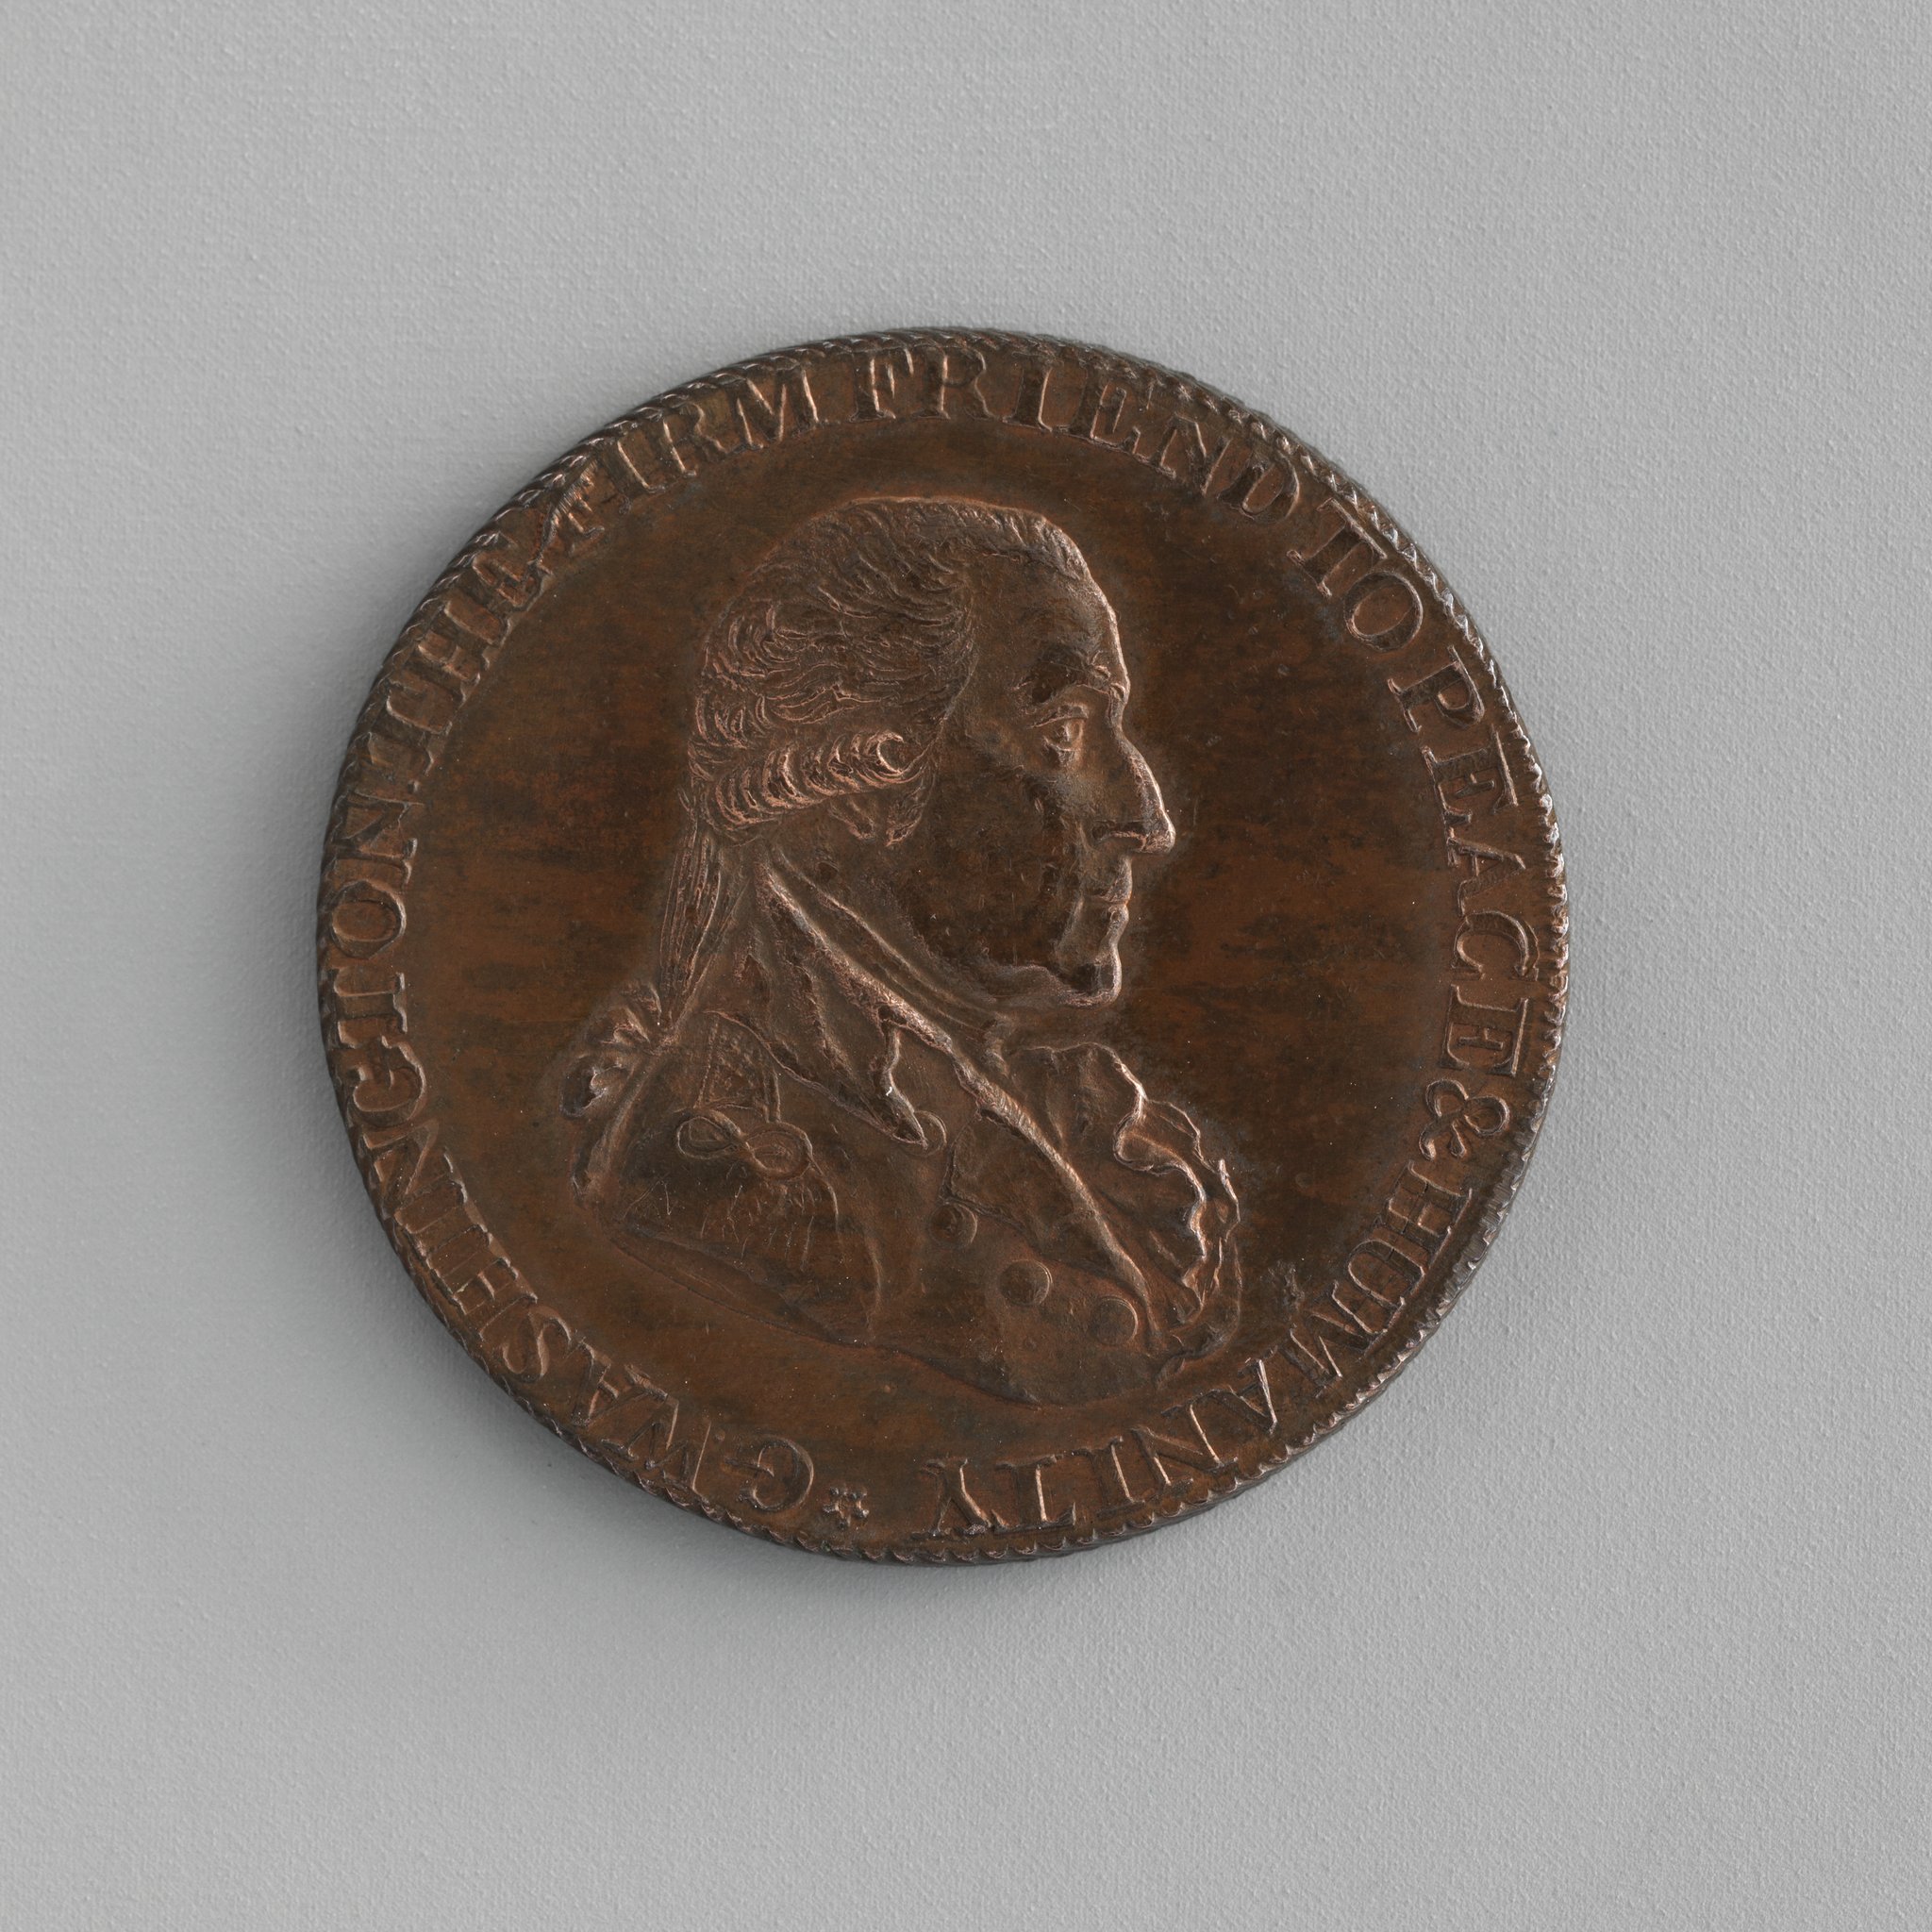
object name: coin or token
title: The "Grate" Token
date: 1795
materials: bronze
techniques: struck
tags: george washington,men,profiles